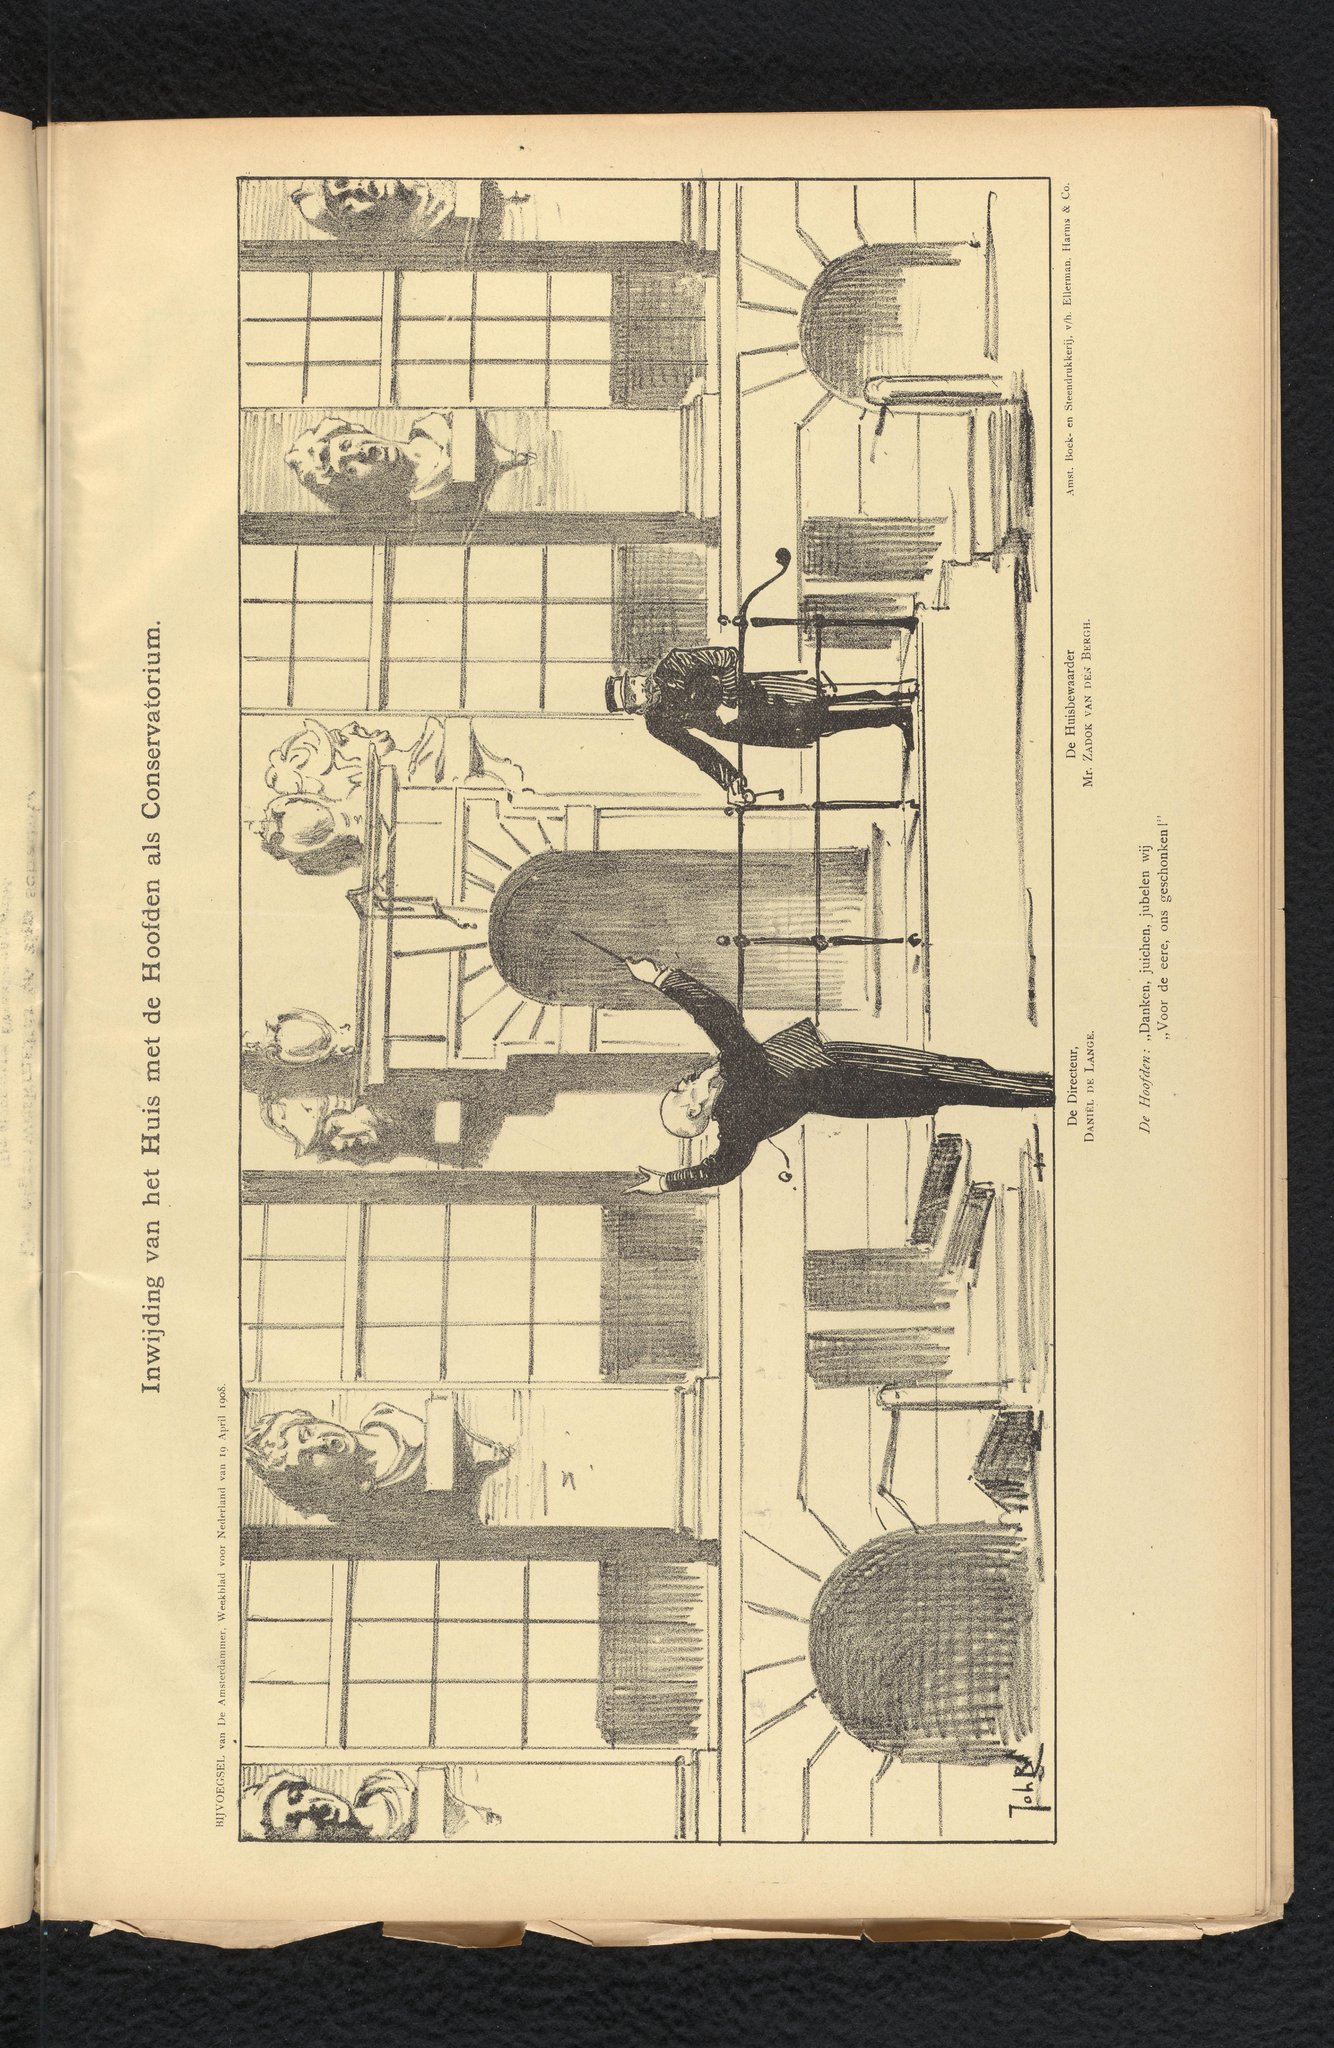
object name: cartoon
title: Inwijding van het Huis met de Hoofden als Conservatorium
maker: johan braakensiek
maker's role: draughtsman, print maker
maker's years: 1858-1940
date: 1908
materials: paper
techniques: lithograph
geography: amsterdam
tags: rotterdam, oss, conductor ~music - cc - out of doors, choir, place or institution of education and training of the artist, e.g.: academy of art, municipal government, political caricatures and satires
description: Componist en koordirigent Daniël de Lange dirigeert de zingende hoofden aan de gevel van het Huis met de Hoofden aan de Keizersgracht te Amsterdam in een jubelzang bij de ingebruikneming van het gebouw als Conservatorium van Amsterdam. Op de trap als de beheerder van het gebouw, wethouder van Publieke Werken Zadok van den Bergh.